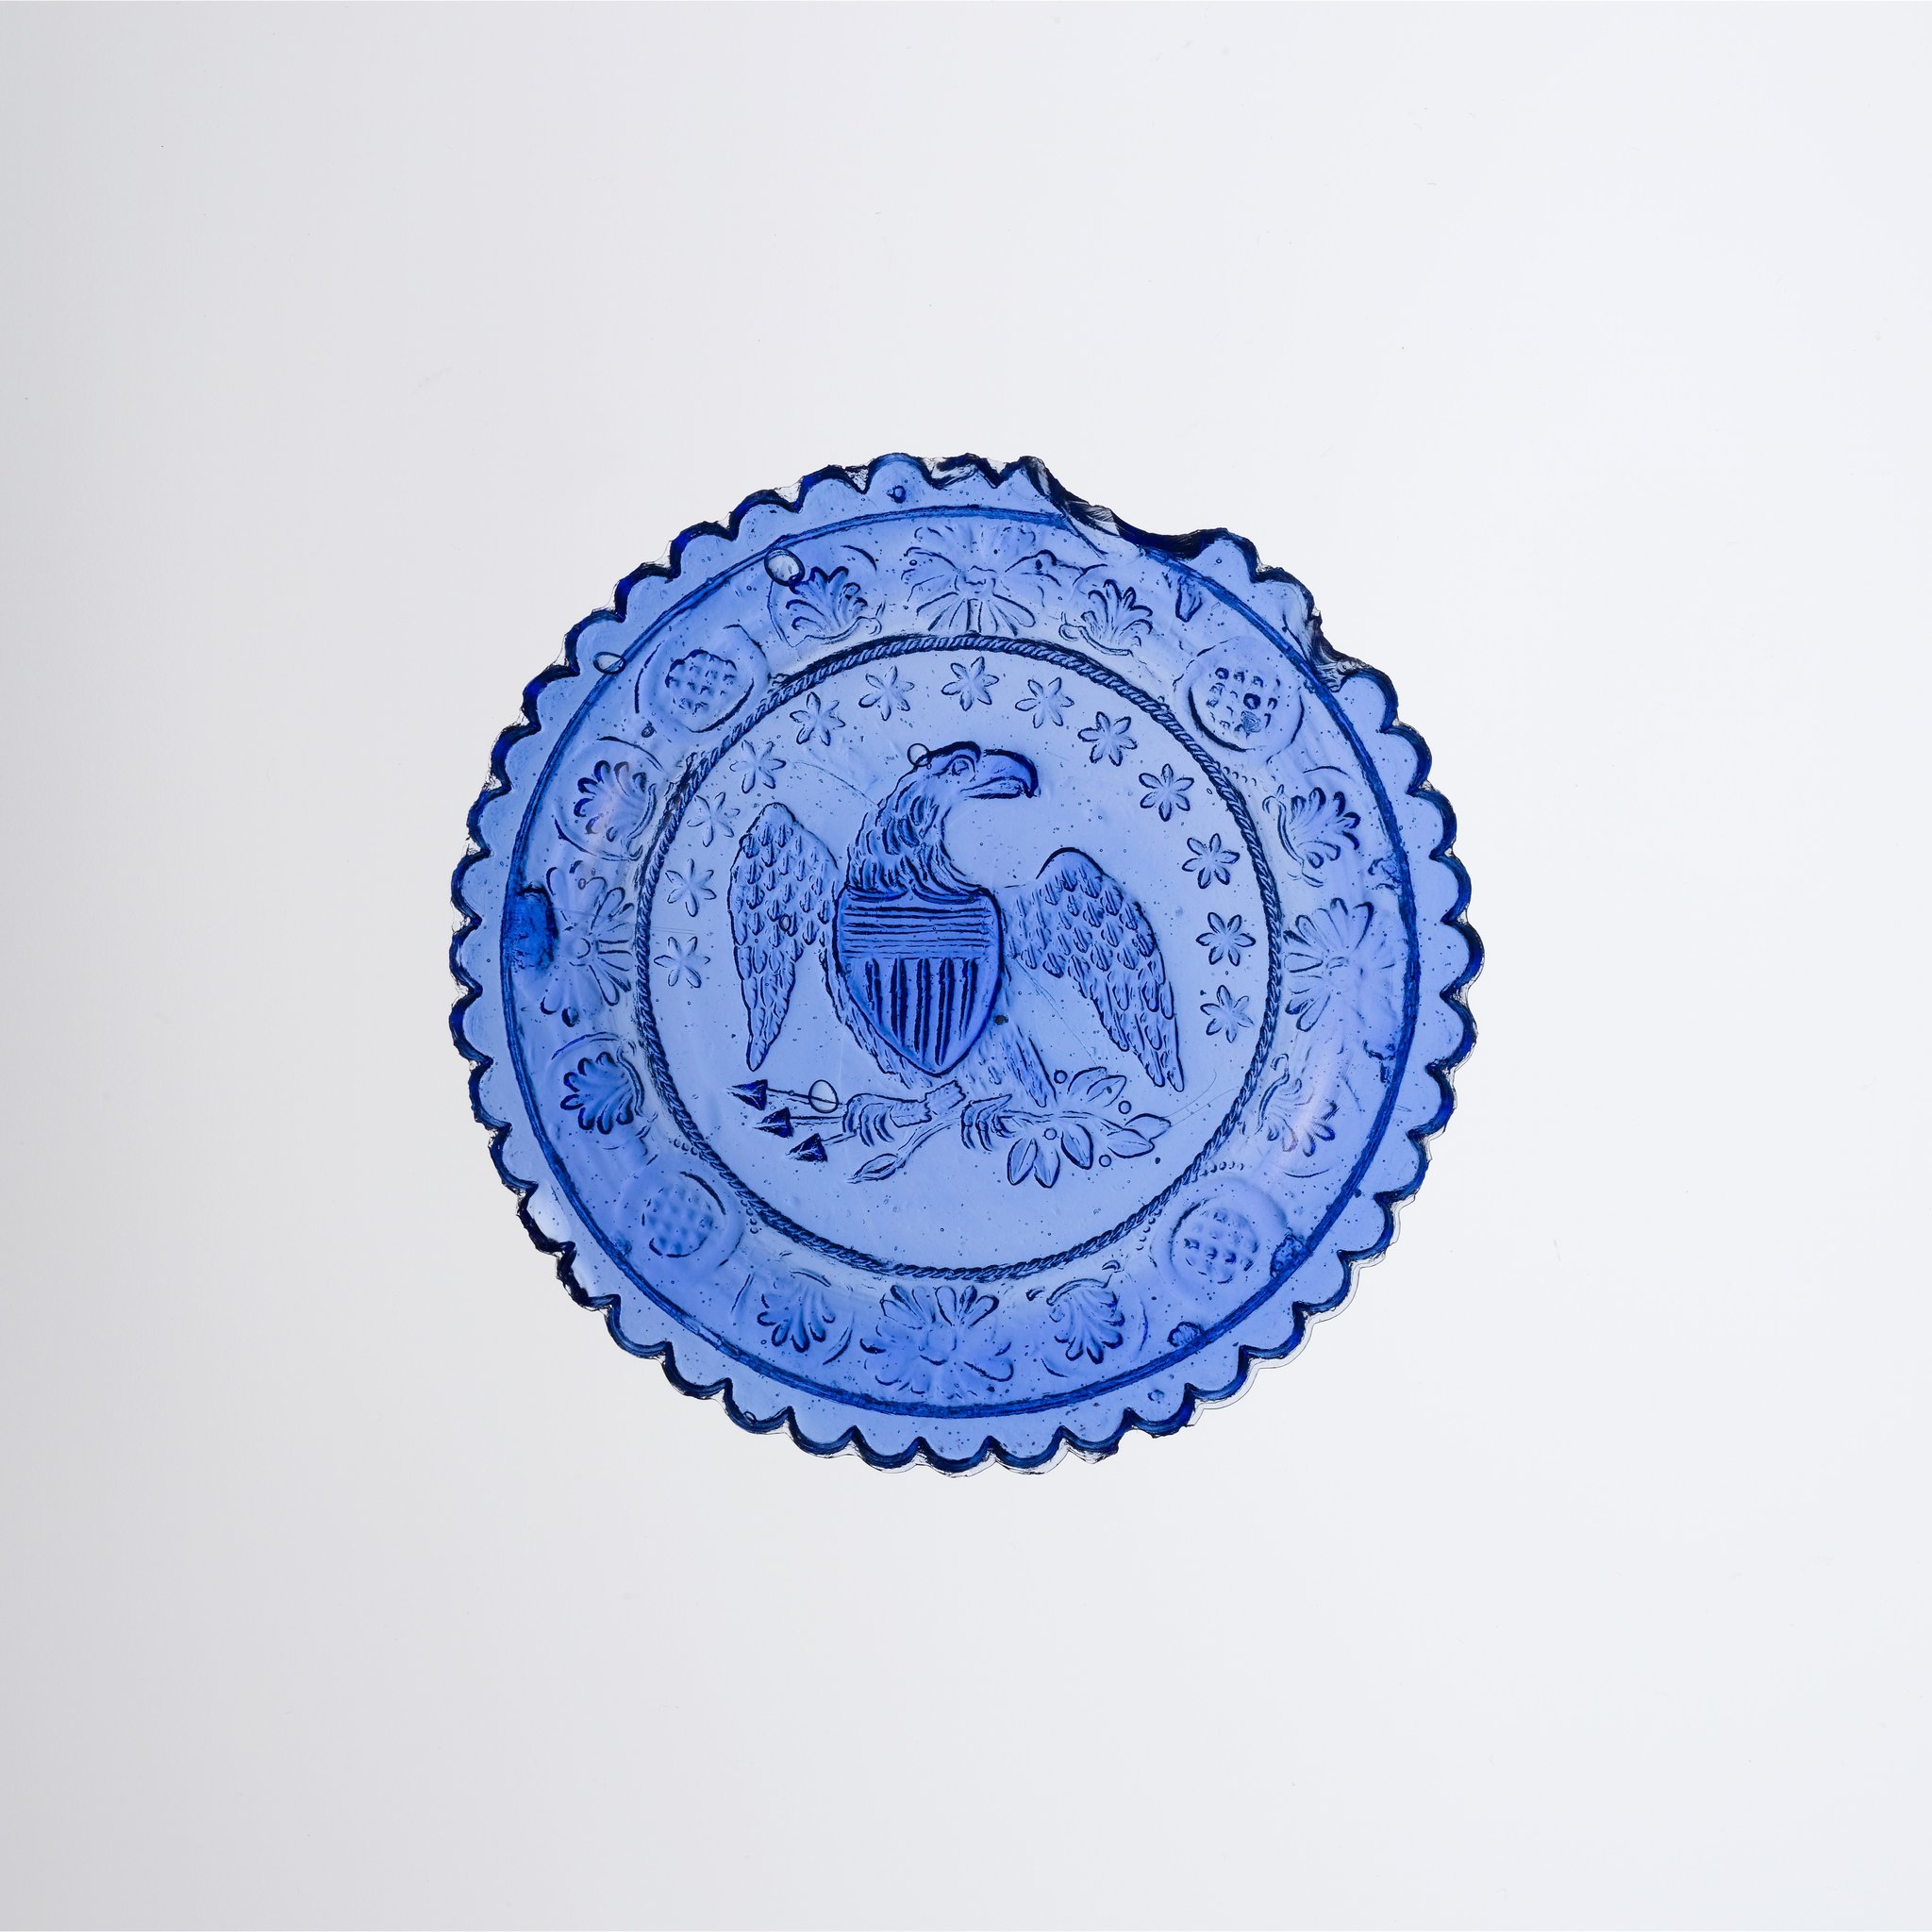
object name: cup plate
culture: american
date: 1825-1860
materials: glass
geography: united states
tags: eagles